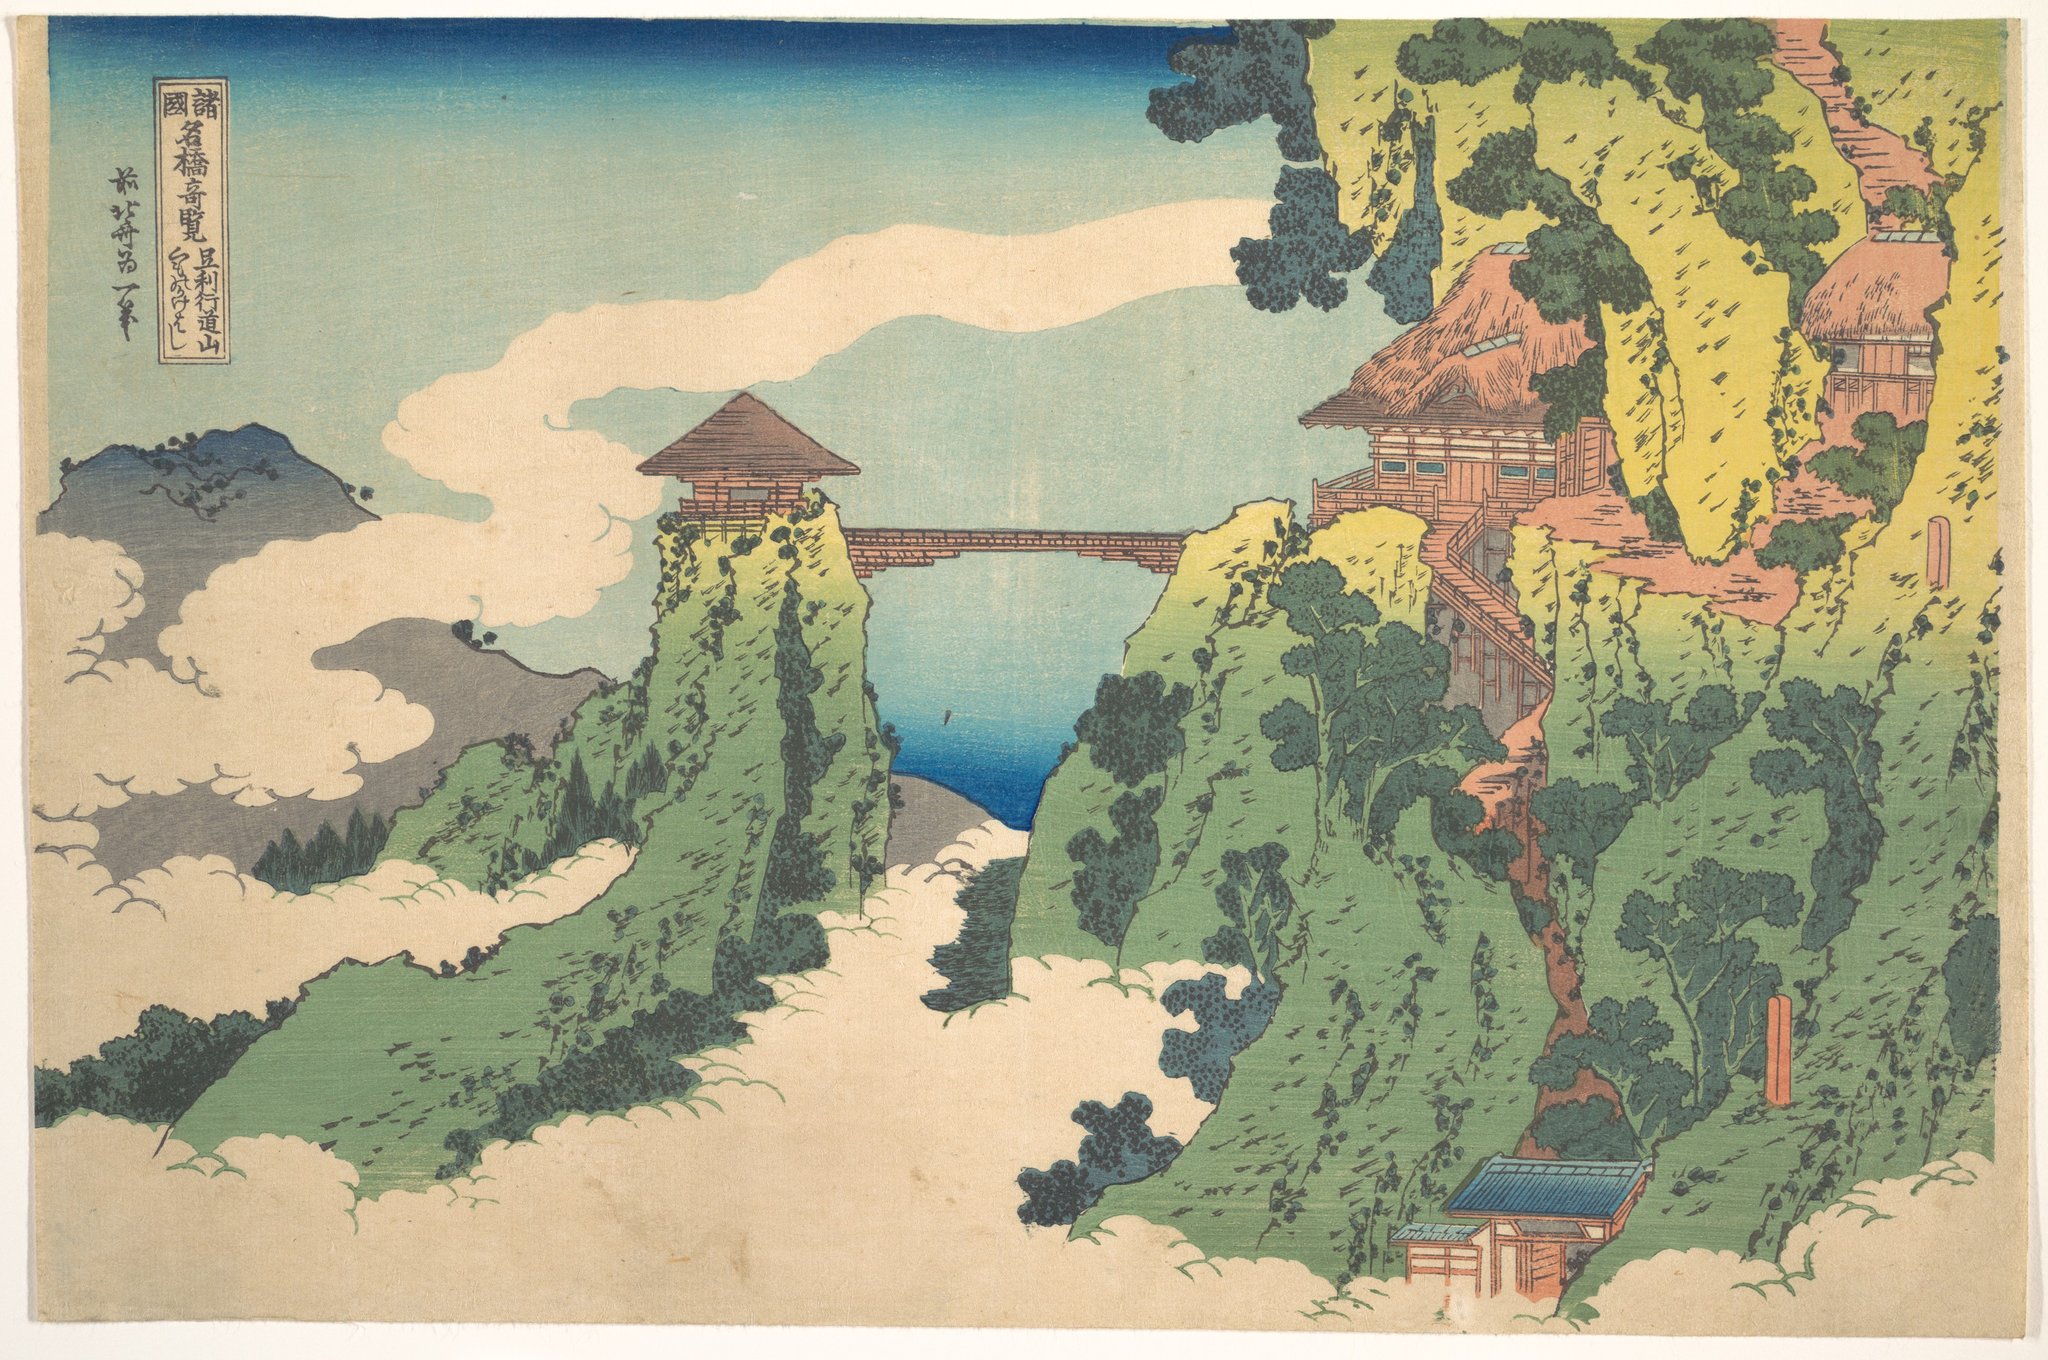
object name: woodblock print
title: The Hanging-cloud Bridge at Mount Gyōdō near Ashikaga (Ashikaga Gyōdōzan kumo no kakehashi), from the series Remarkable Views of Bridges in Various Provinces (Shokoku meikyō kiran)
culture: japanese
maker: katsushika hokusai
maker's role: artist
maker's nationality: japanese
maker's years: 1760-1849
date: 1760-1849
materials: ink, paper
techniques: woodblock print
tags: houses,bridges,mountains,trees